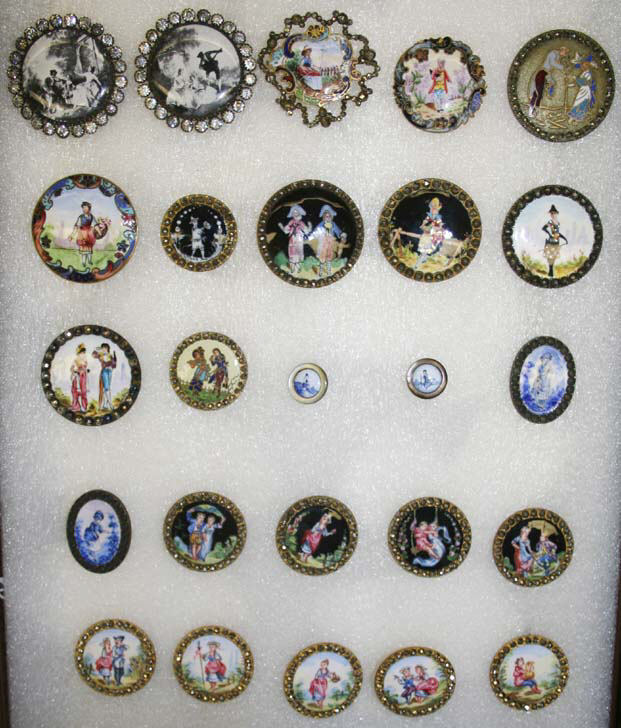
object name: button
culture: french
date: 1850-1880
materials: enamel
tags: couples,men,women